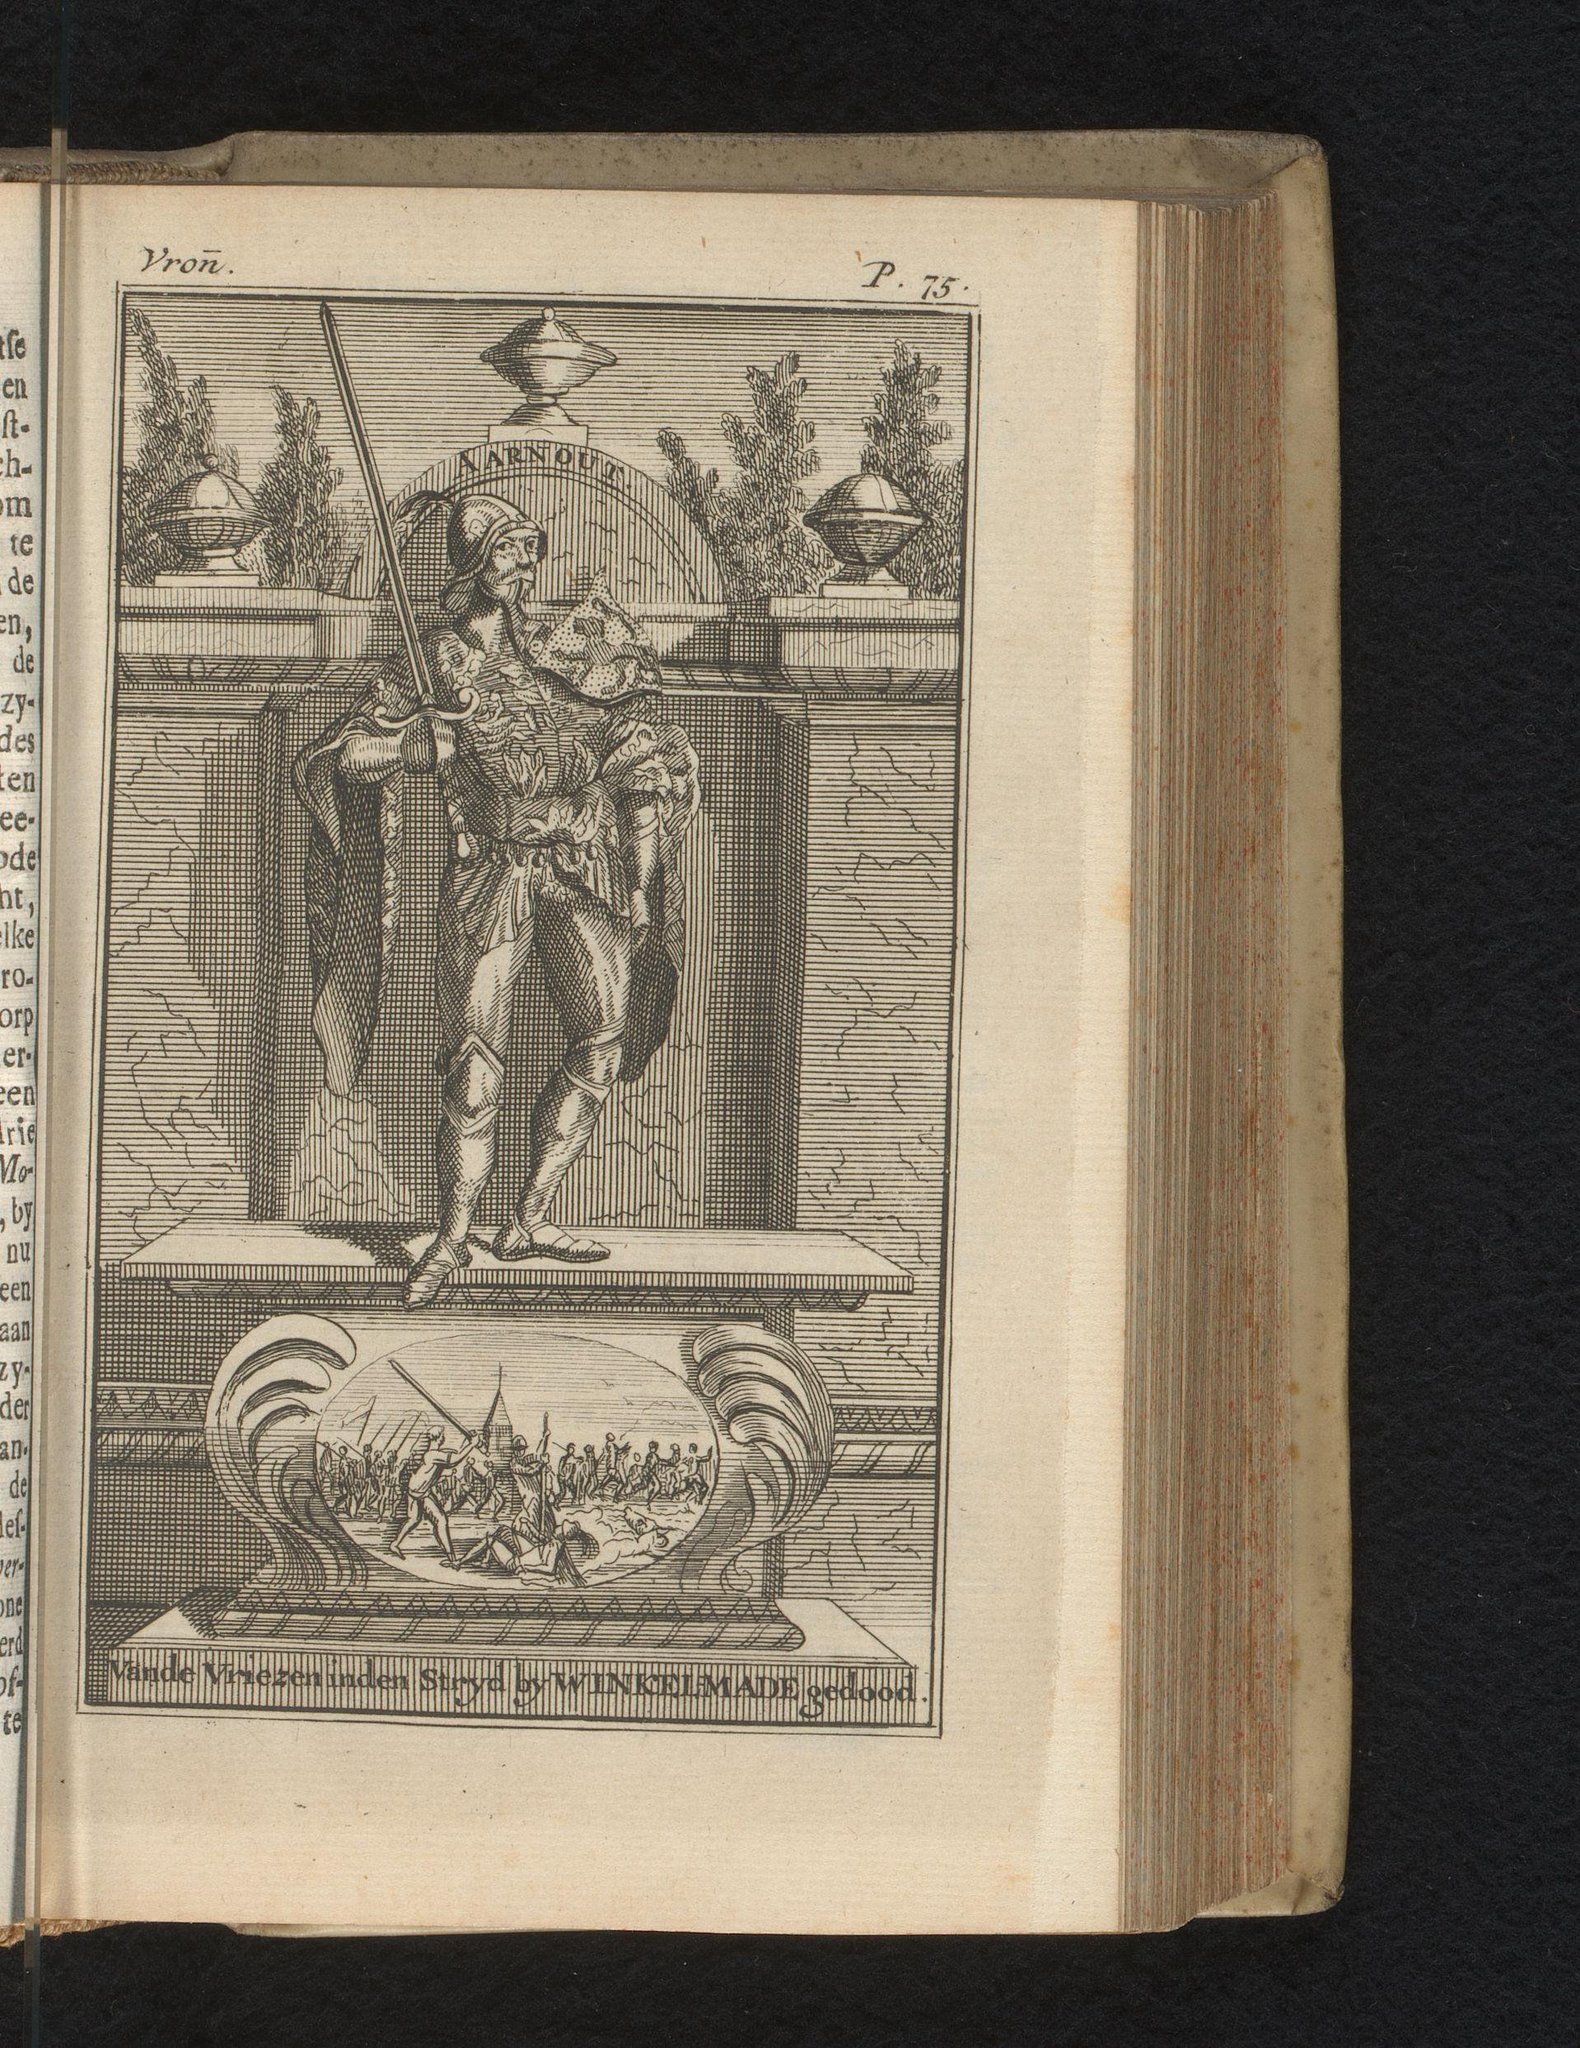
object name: history print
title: Aarnout, graaf van Holland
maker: pieter van den berge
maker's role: draughtsman, print maker, printer, publisher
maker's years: 1659-1737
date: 1700-1702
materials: paper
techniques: etching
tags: ghent, earl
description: Illustratie in: H. Soeteboom, Oud-heden van Zaan-land, Stavoren, Vronen en Waterland : deze laatste druk ... met nodige aanteekeningen, figuren, en een landkaart verrykt / Vroonens Begin Midden en Eynde, W. Linnig van Koppenol, Amsterdam 1702, dl. 2, ingebonden tussen p. 74/75.